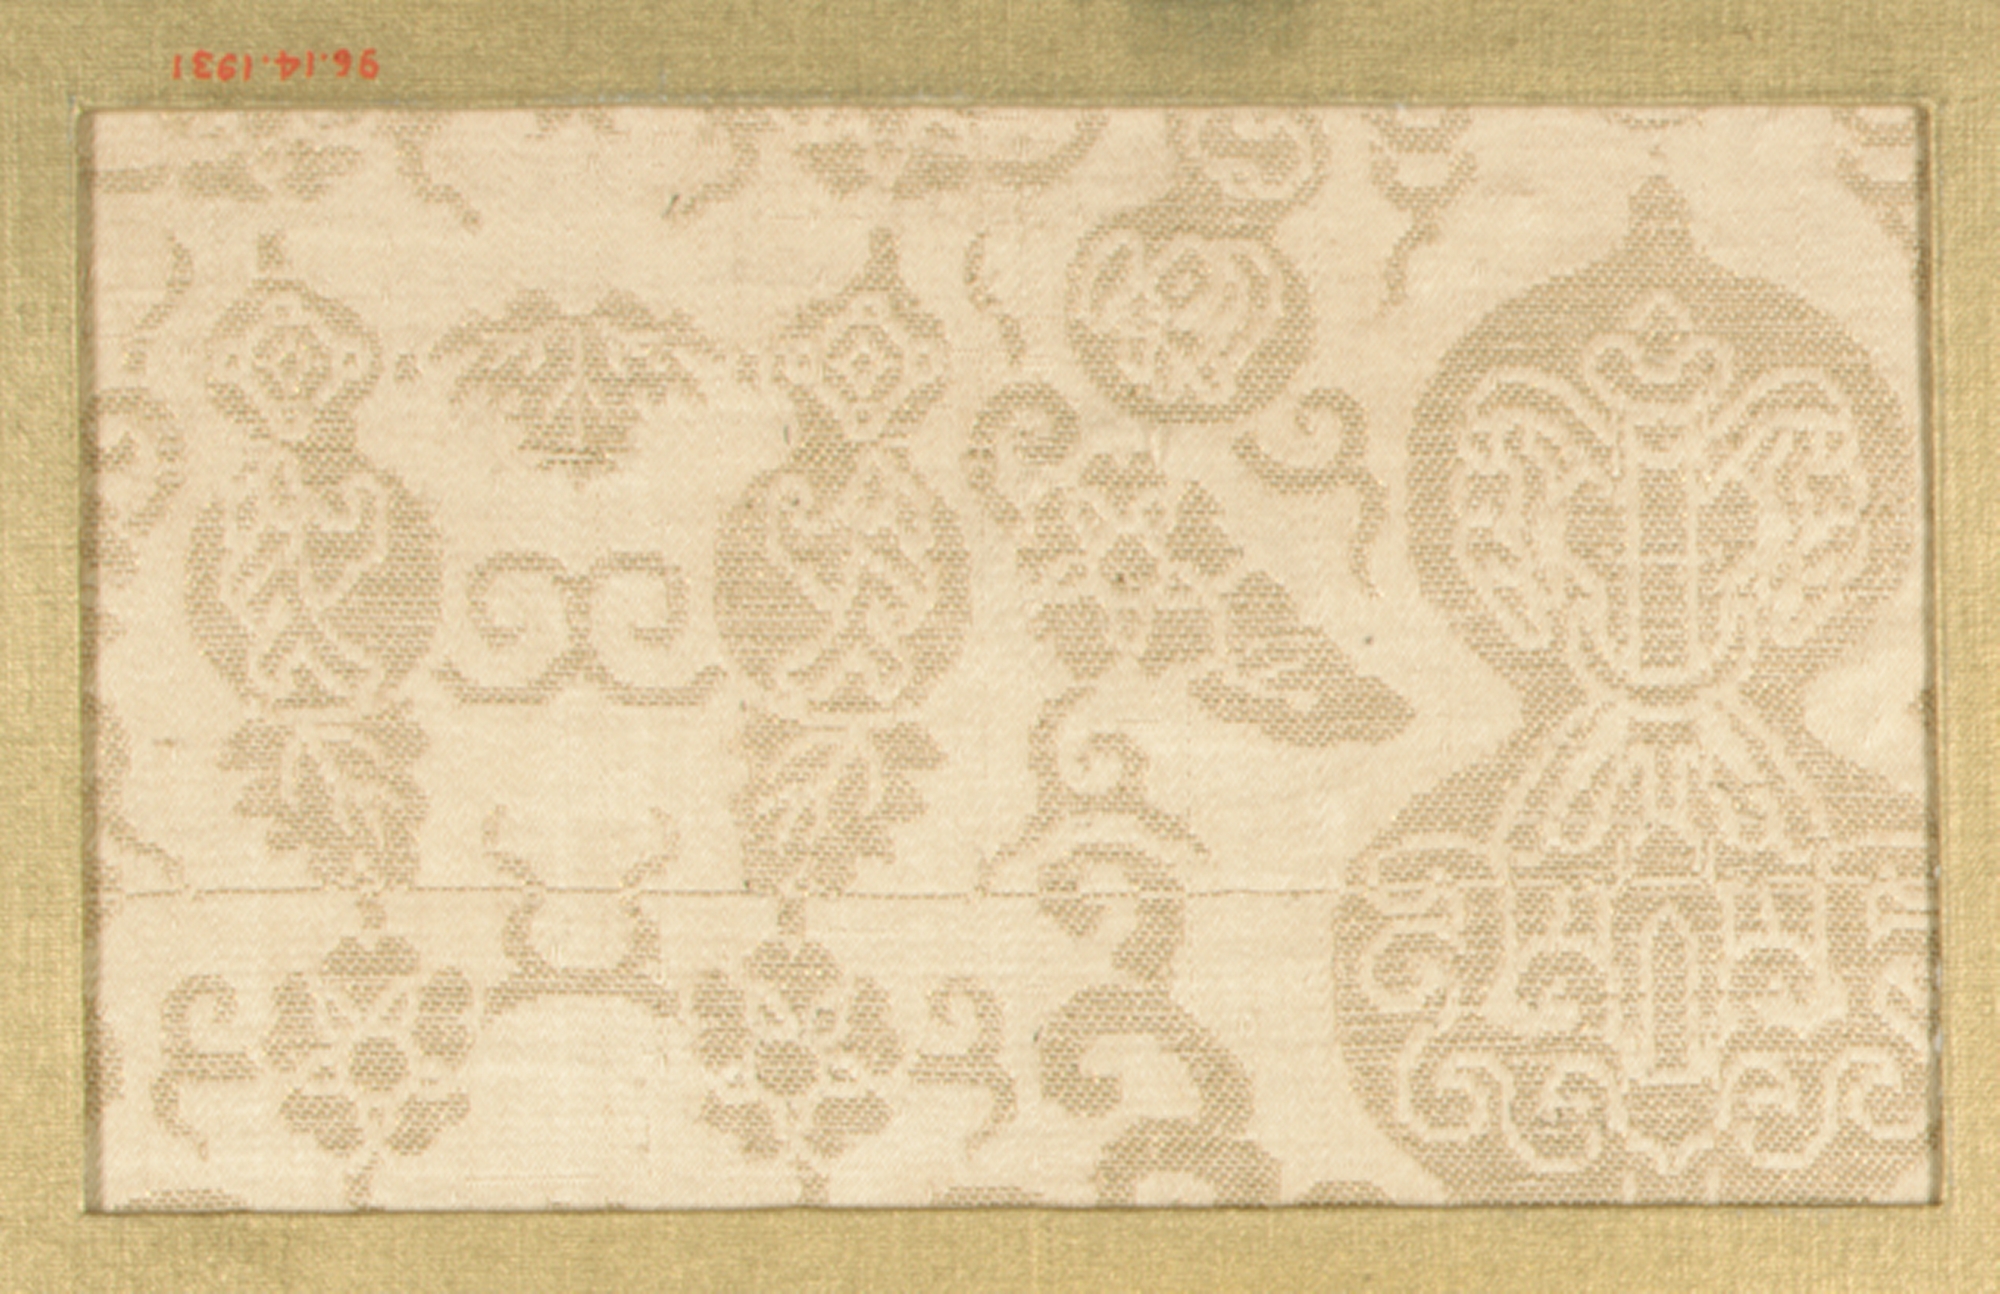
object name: piece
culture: japanese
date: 1701-1900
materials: silk